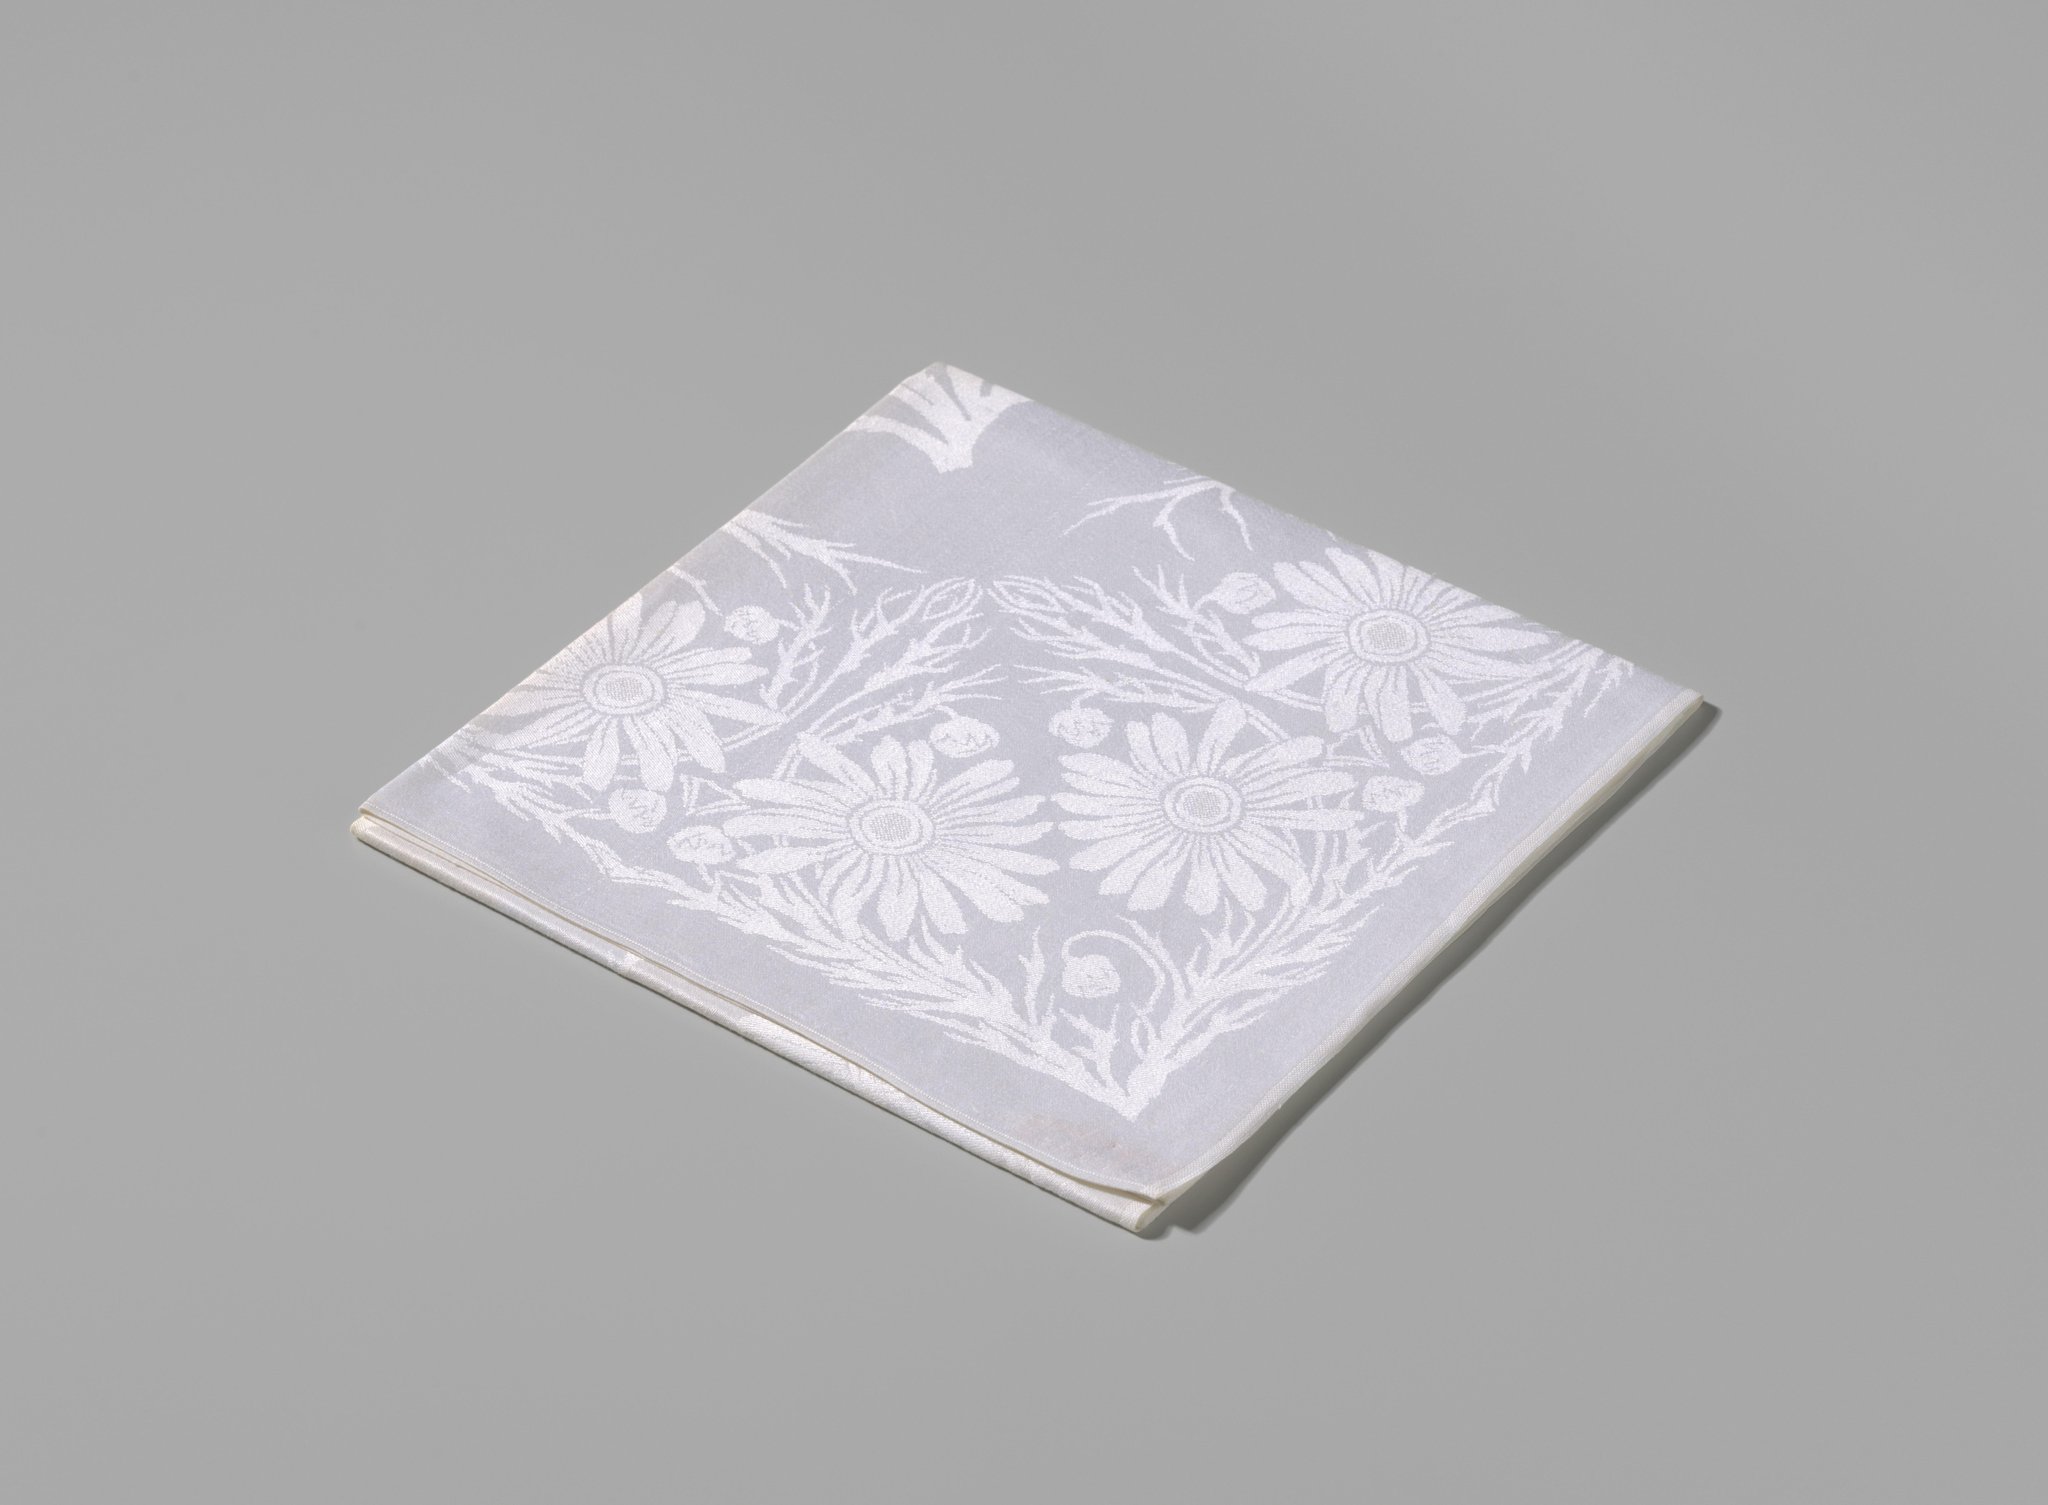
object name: napkin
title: Servet van linnendamast met dessin Marguerite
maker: cornelis van der sluys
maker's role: print maker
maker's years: 1881-1944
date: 1904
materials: linen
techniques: damask, weave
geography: eindhoven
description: Servet van linnendamast met een bloempatroon: motief Marguerite, dessin nr. 500. Het servet hoort bij twaalf servetten, twaalf vingerdoeken en een tafellaken.